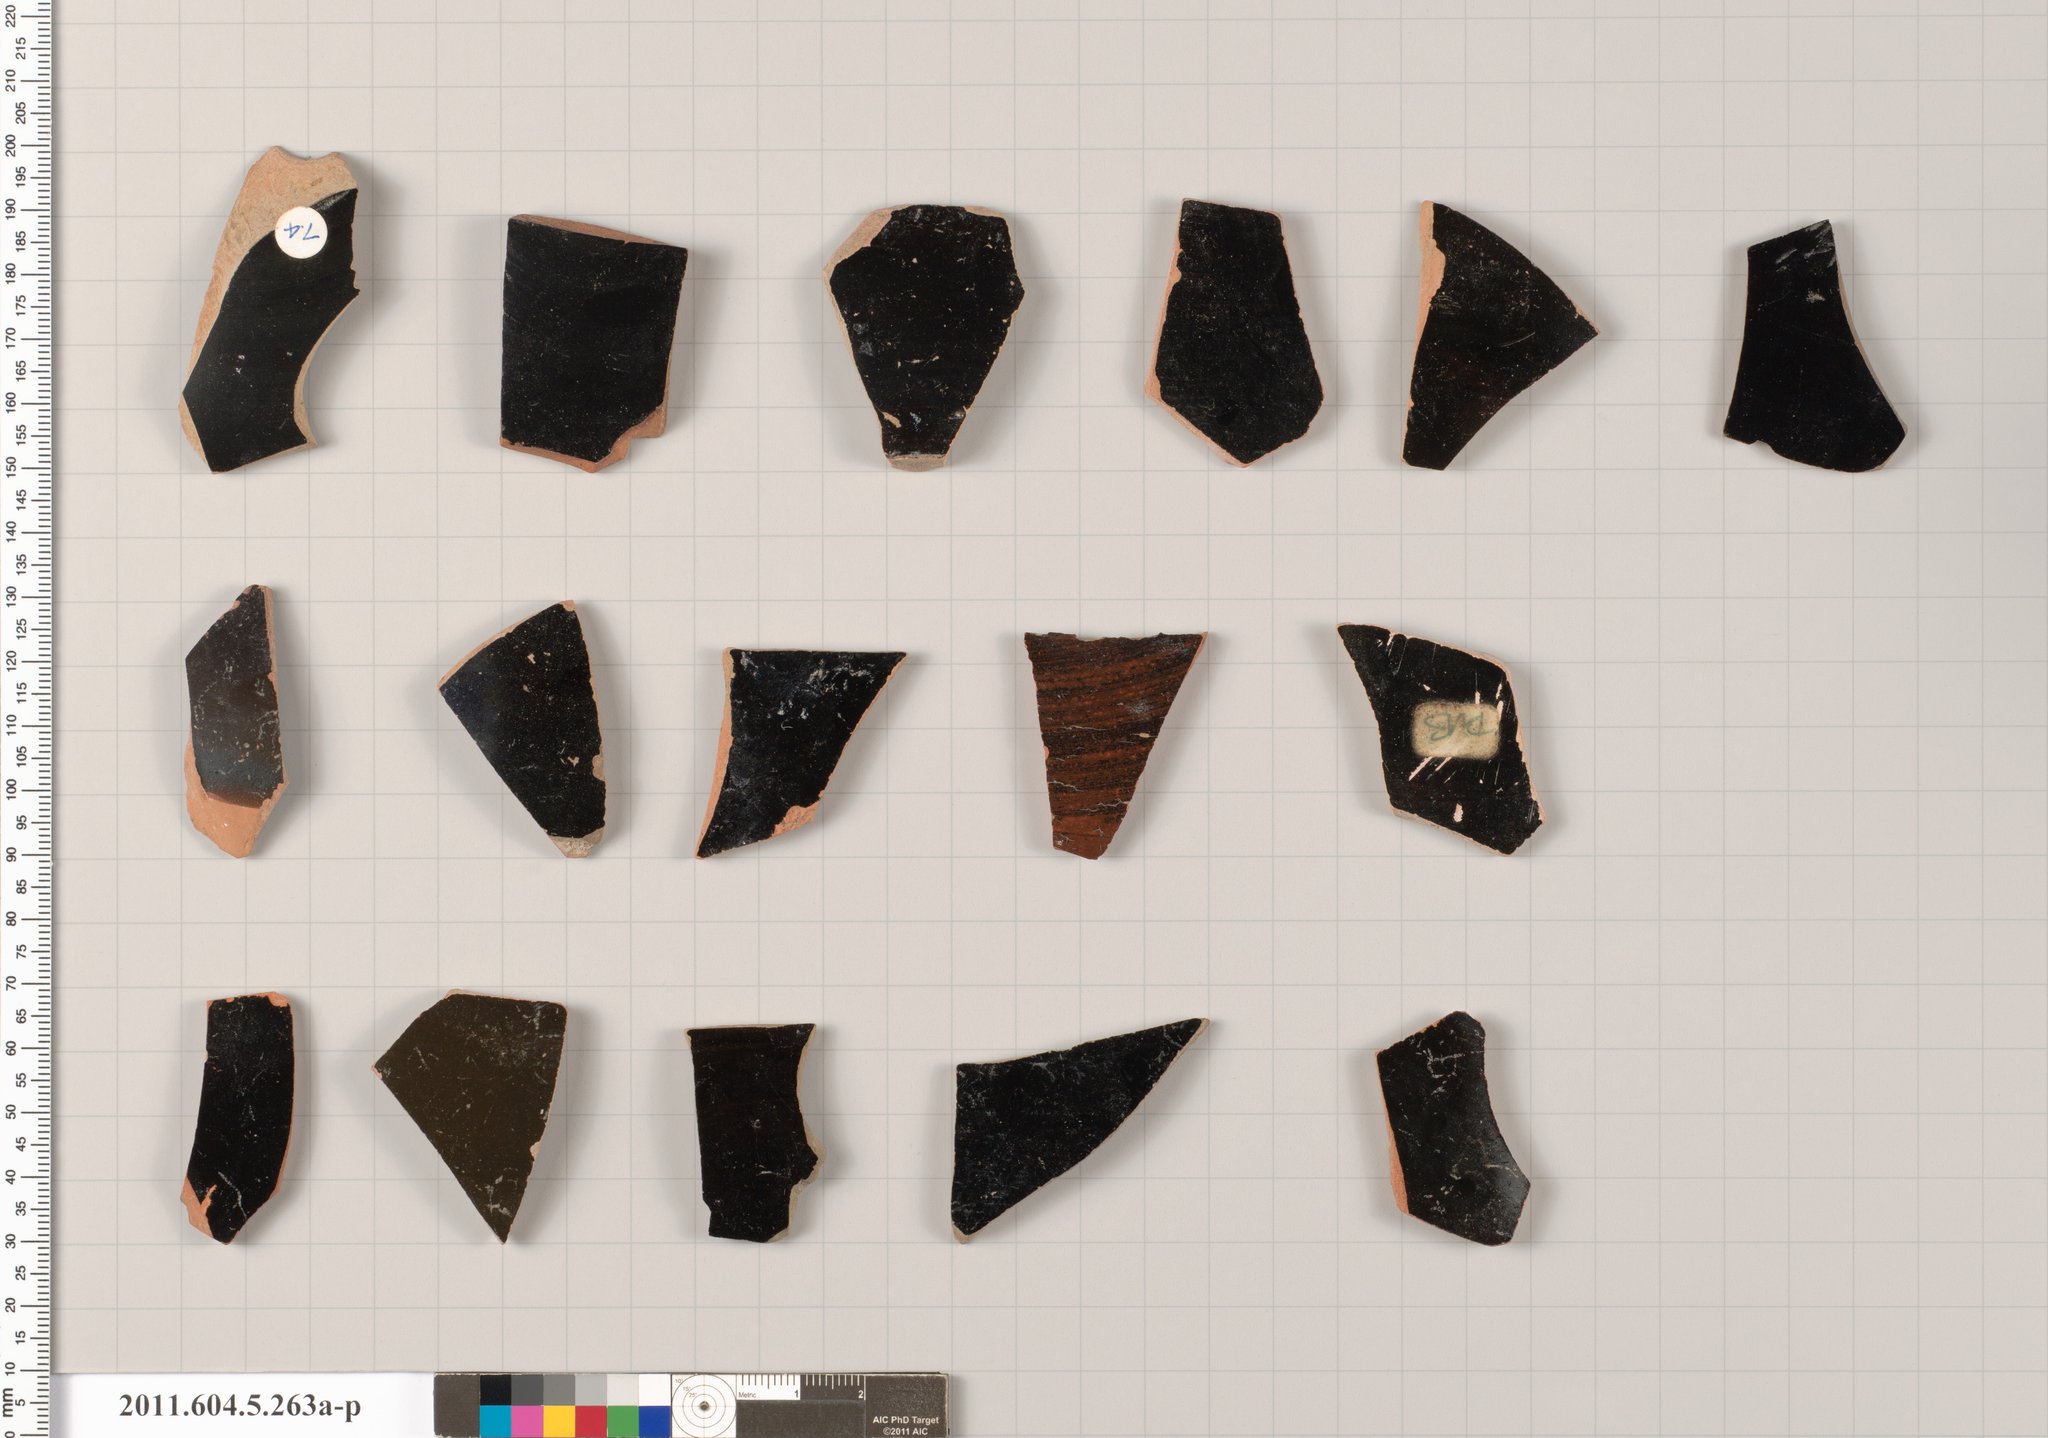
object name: kylix fragment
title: Terracotta fragments of kylikes (drinking cups)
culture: greek, attic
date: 600-401 BCE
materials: terracotta